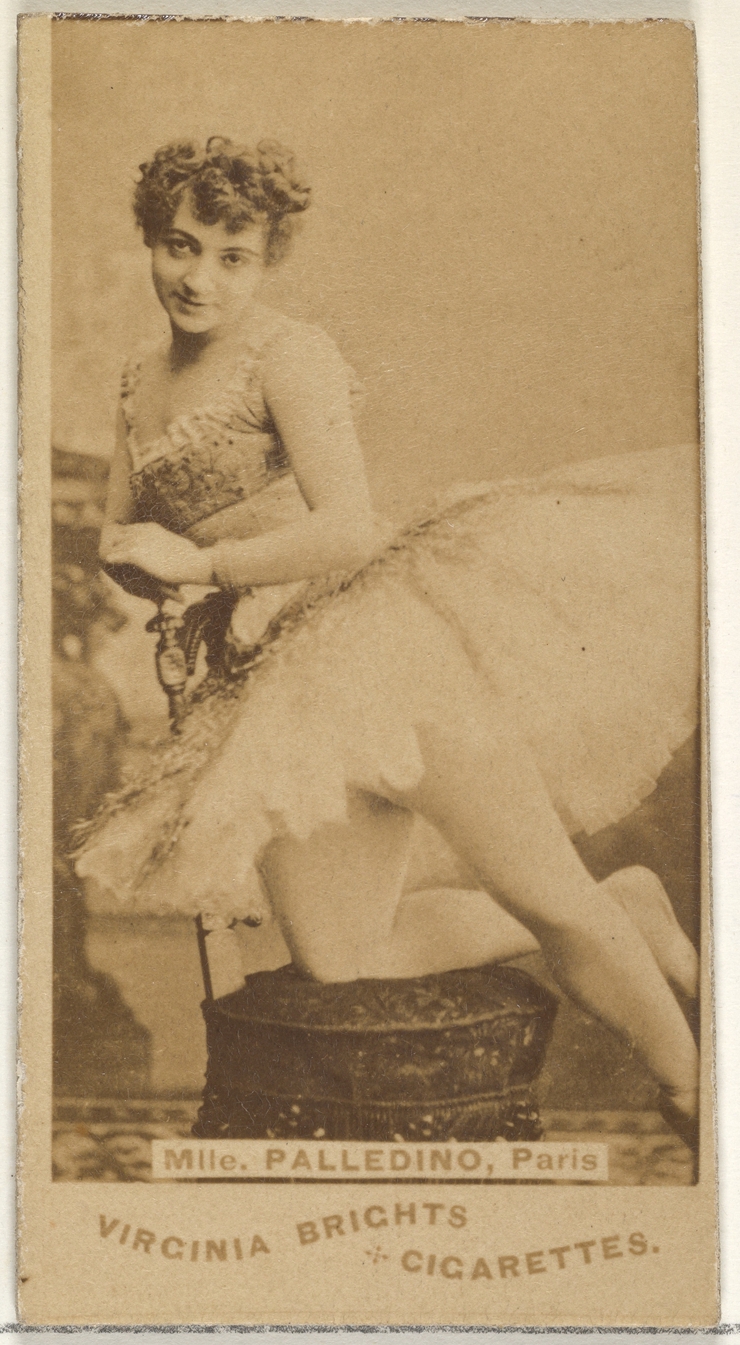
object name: photograph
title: Mlle. Palledino, Paris, from the Actors and Actresses series (N45, Type 1) for Virginia Brights Cigarettes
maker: allen & ginter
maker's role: publisher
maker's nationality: american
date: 1888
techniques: albumen silver print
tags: portraits,women,actresses